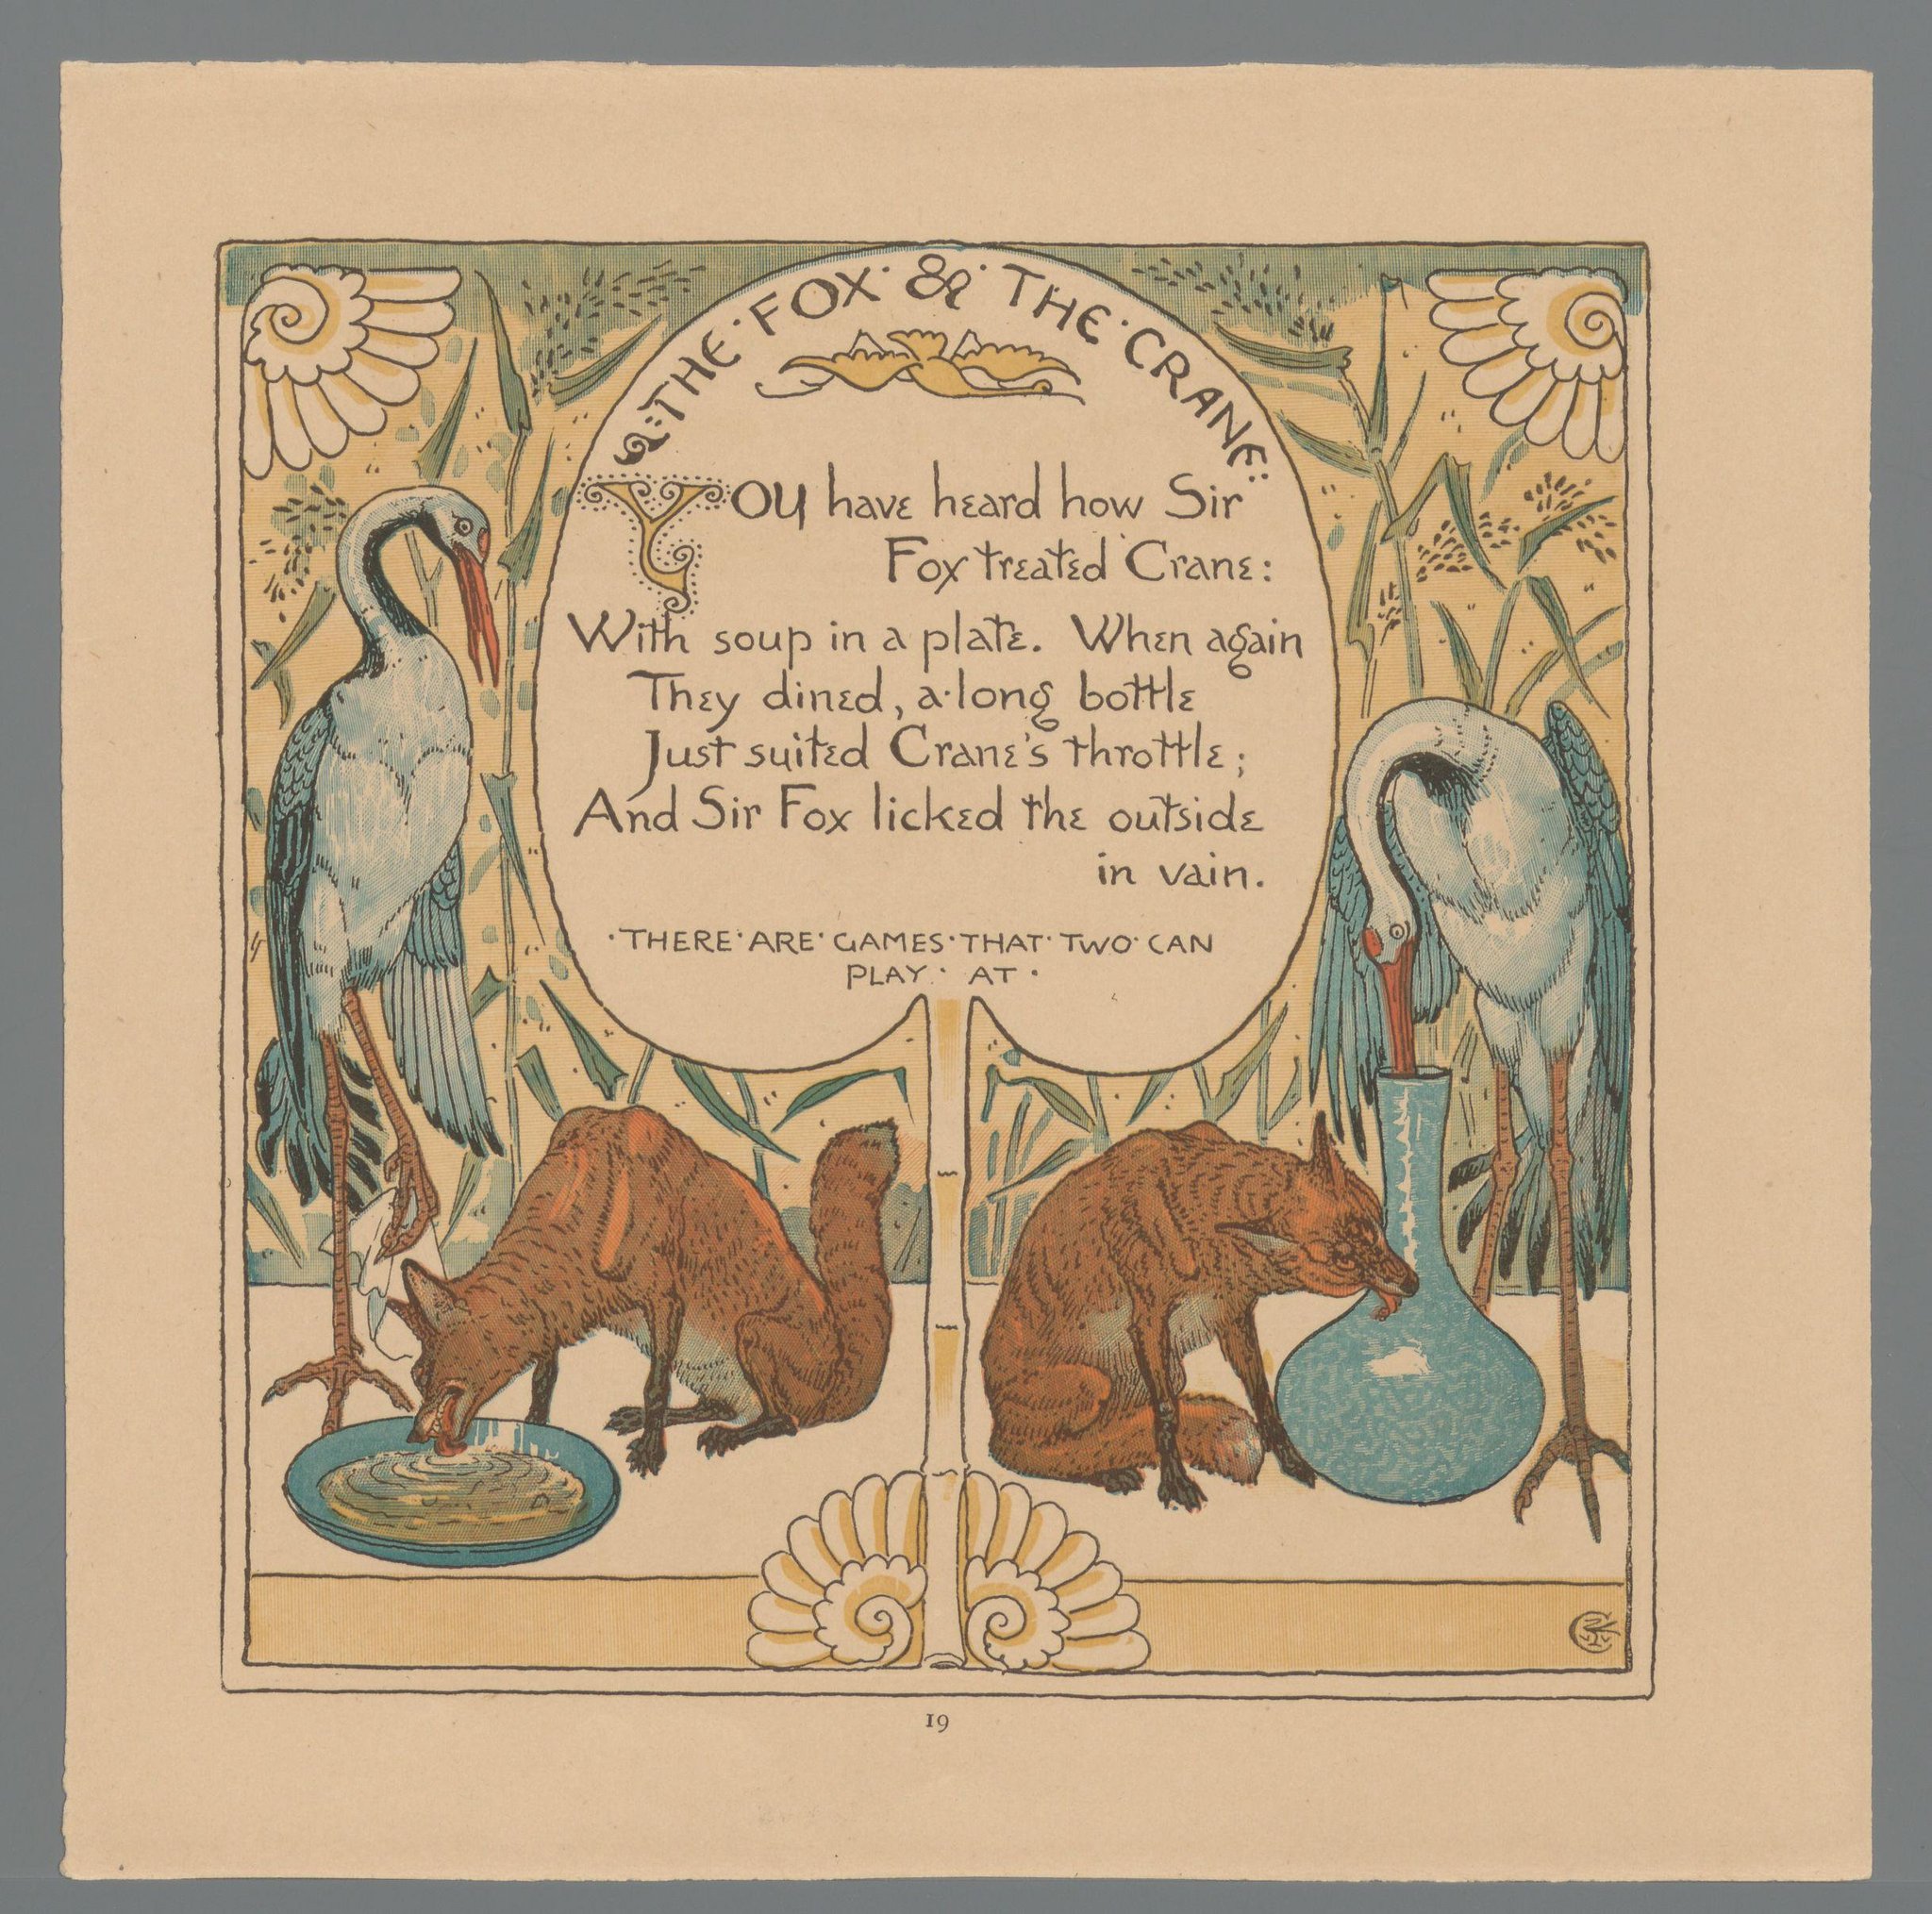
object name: print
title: The fox & the crane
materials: paper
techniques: wood engraving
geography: london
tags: shore-birds and wading-birds: crane, container of ceramics: jar, jug, pot, vase, beasts of prey, predatory animals: fox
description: Prent uit: The baby's own Aesop being the fables condensed in rhyme. Londen: Routledge & Sons, 1887. Of een latere uitgave.